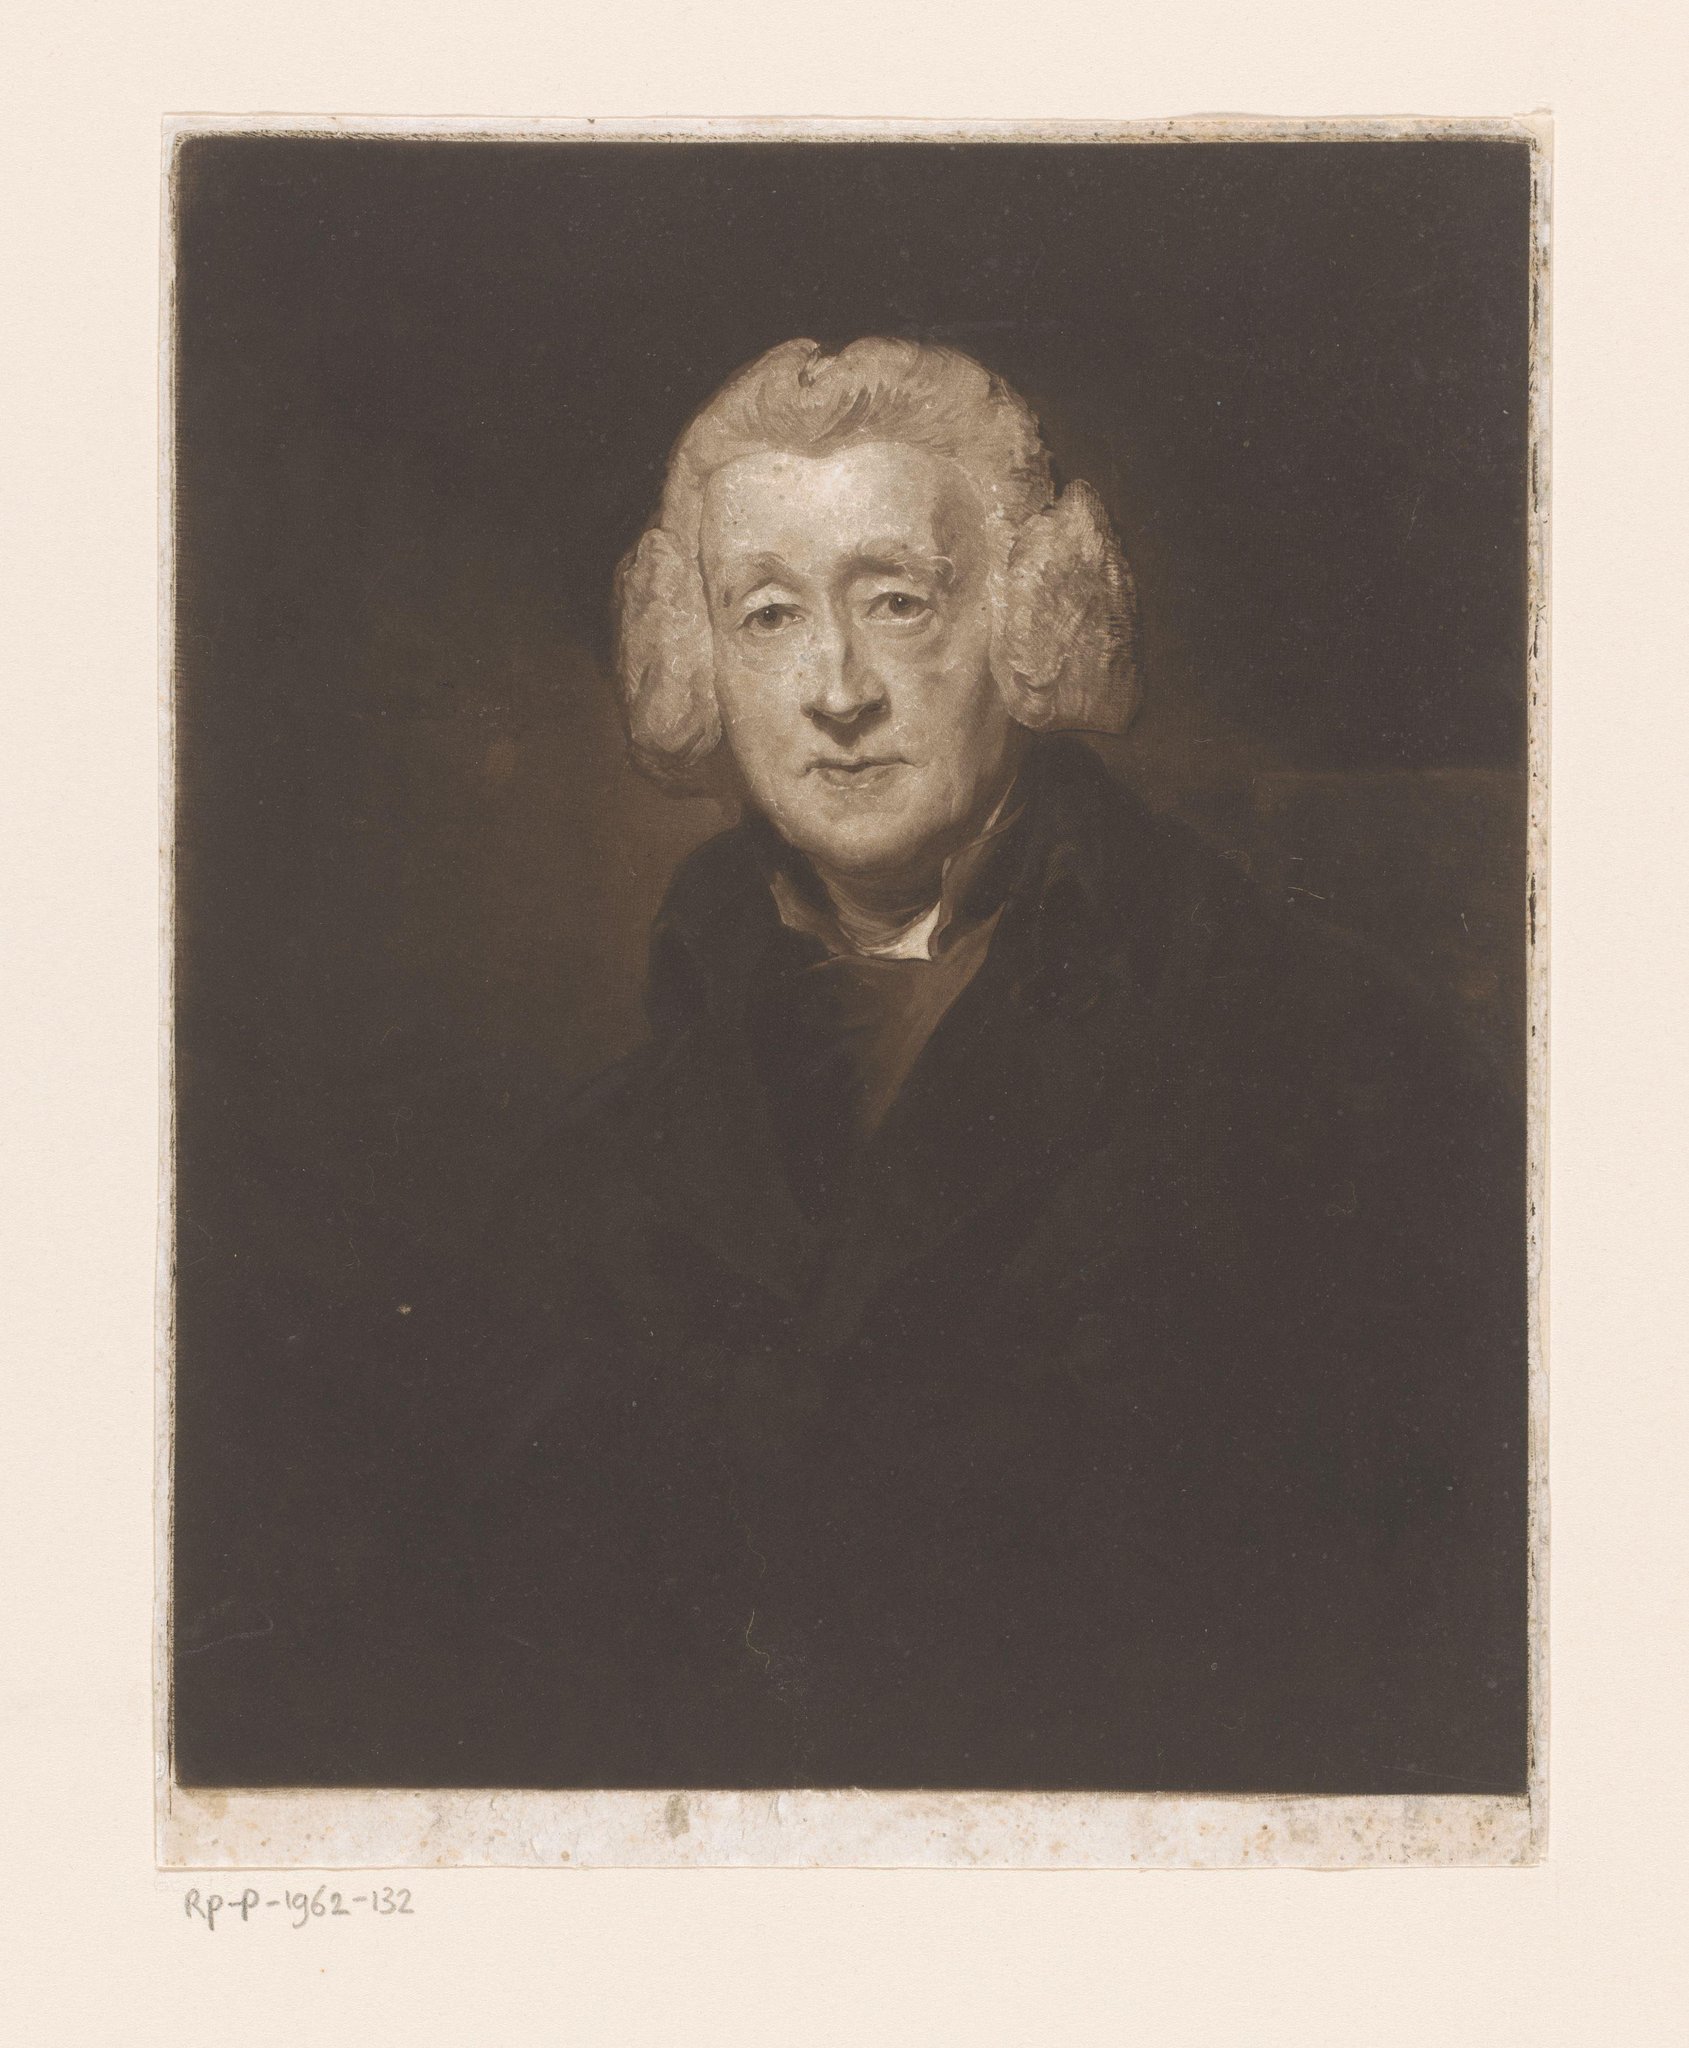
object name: print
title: Portret van een onbekende man met pruik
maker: Anonymous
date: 1800-1850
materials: paper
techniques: mezzotint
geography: england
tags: anonymous historical person portrayed alone, wig